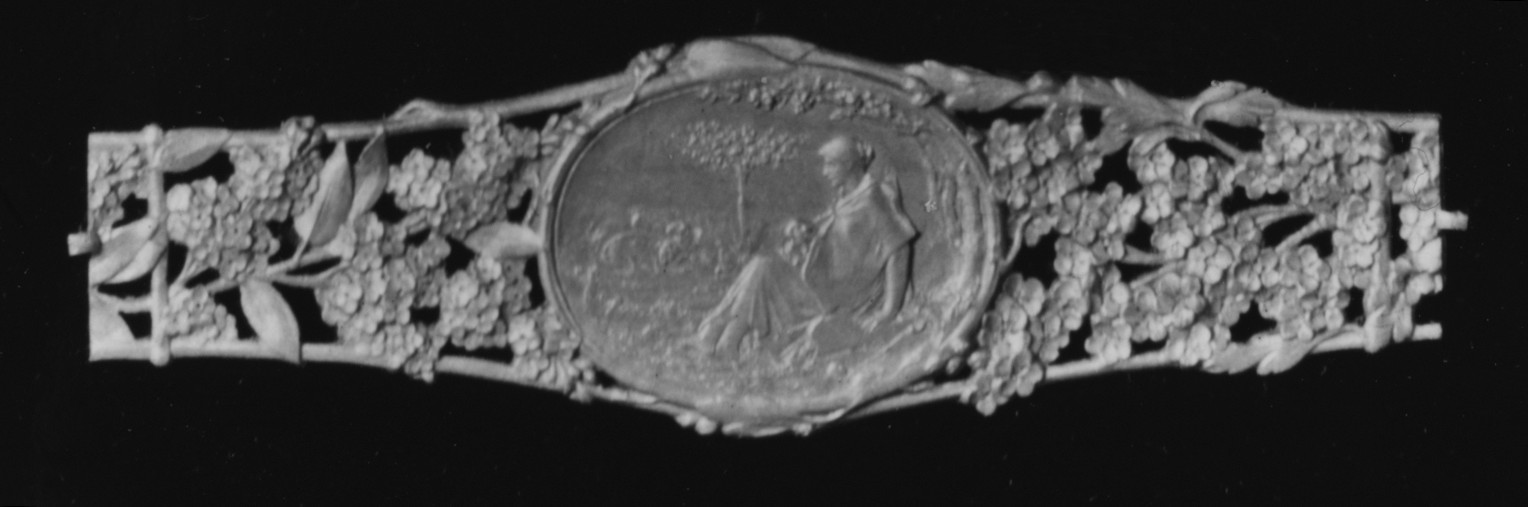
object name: bracelet design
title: Design for a bracelet (in two pieces)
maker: louis-oscar roty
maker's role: artist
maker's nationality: french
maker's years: 1846-1911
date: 1801-1900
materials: gilt bronze